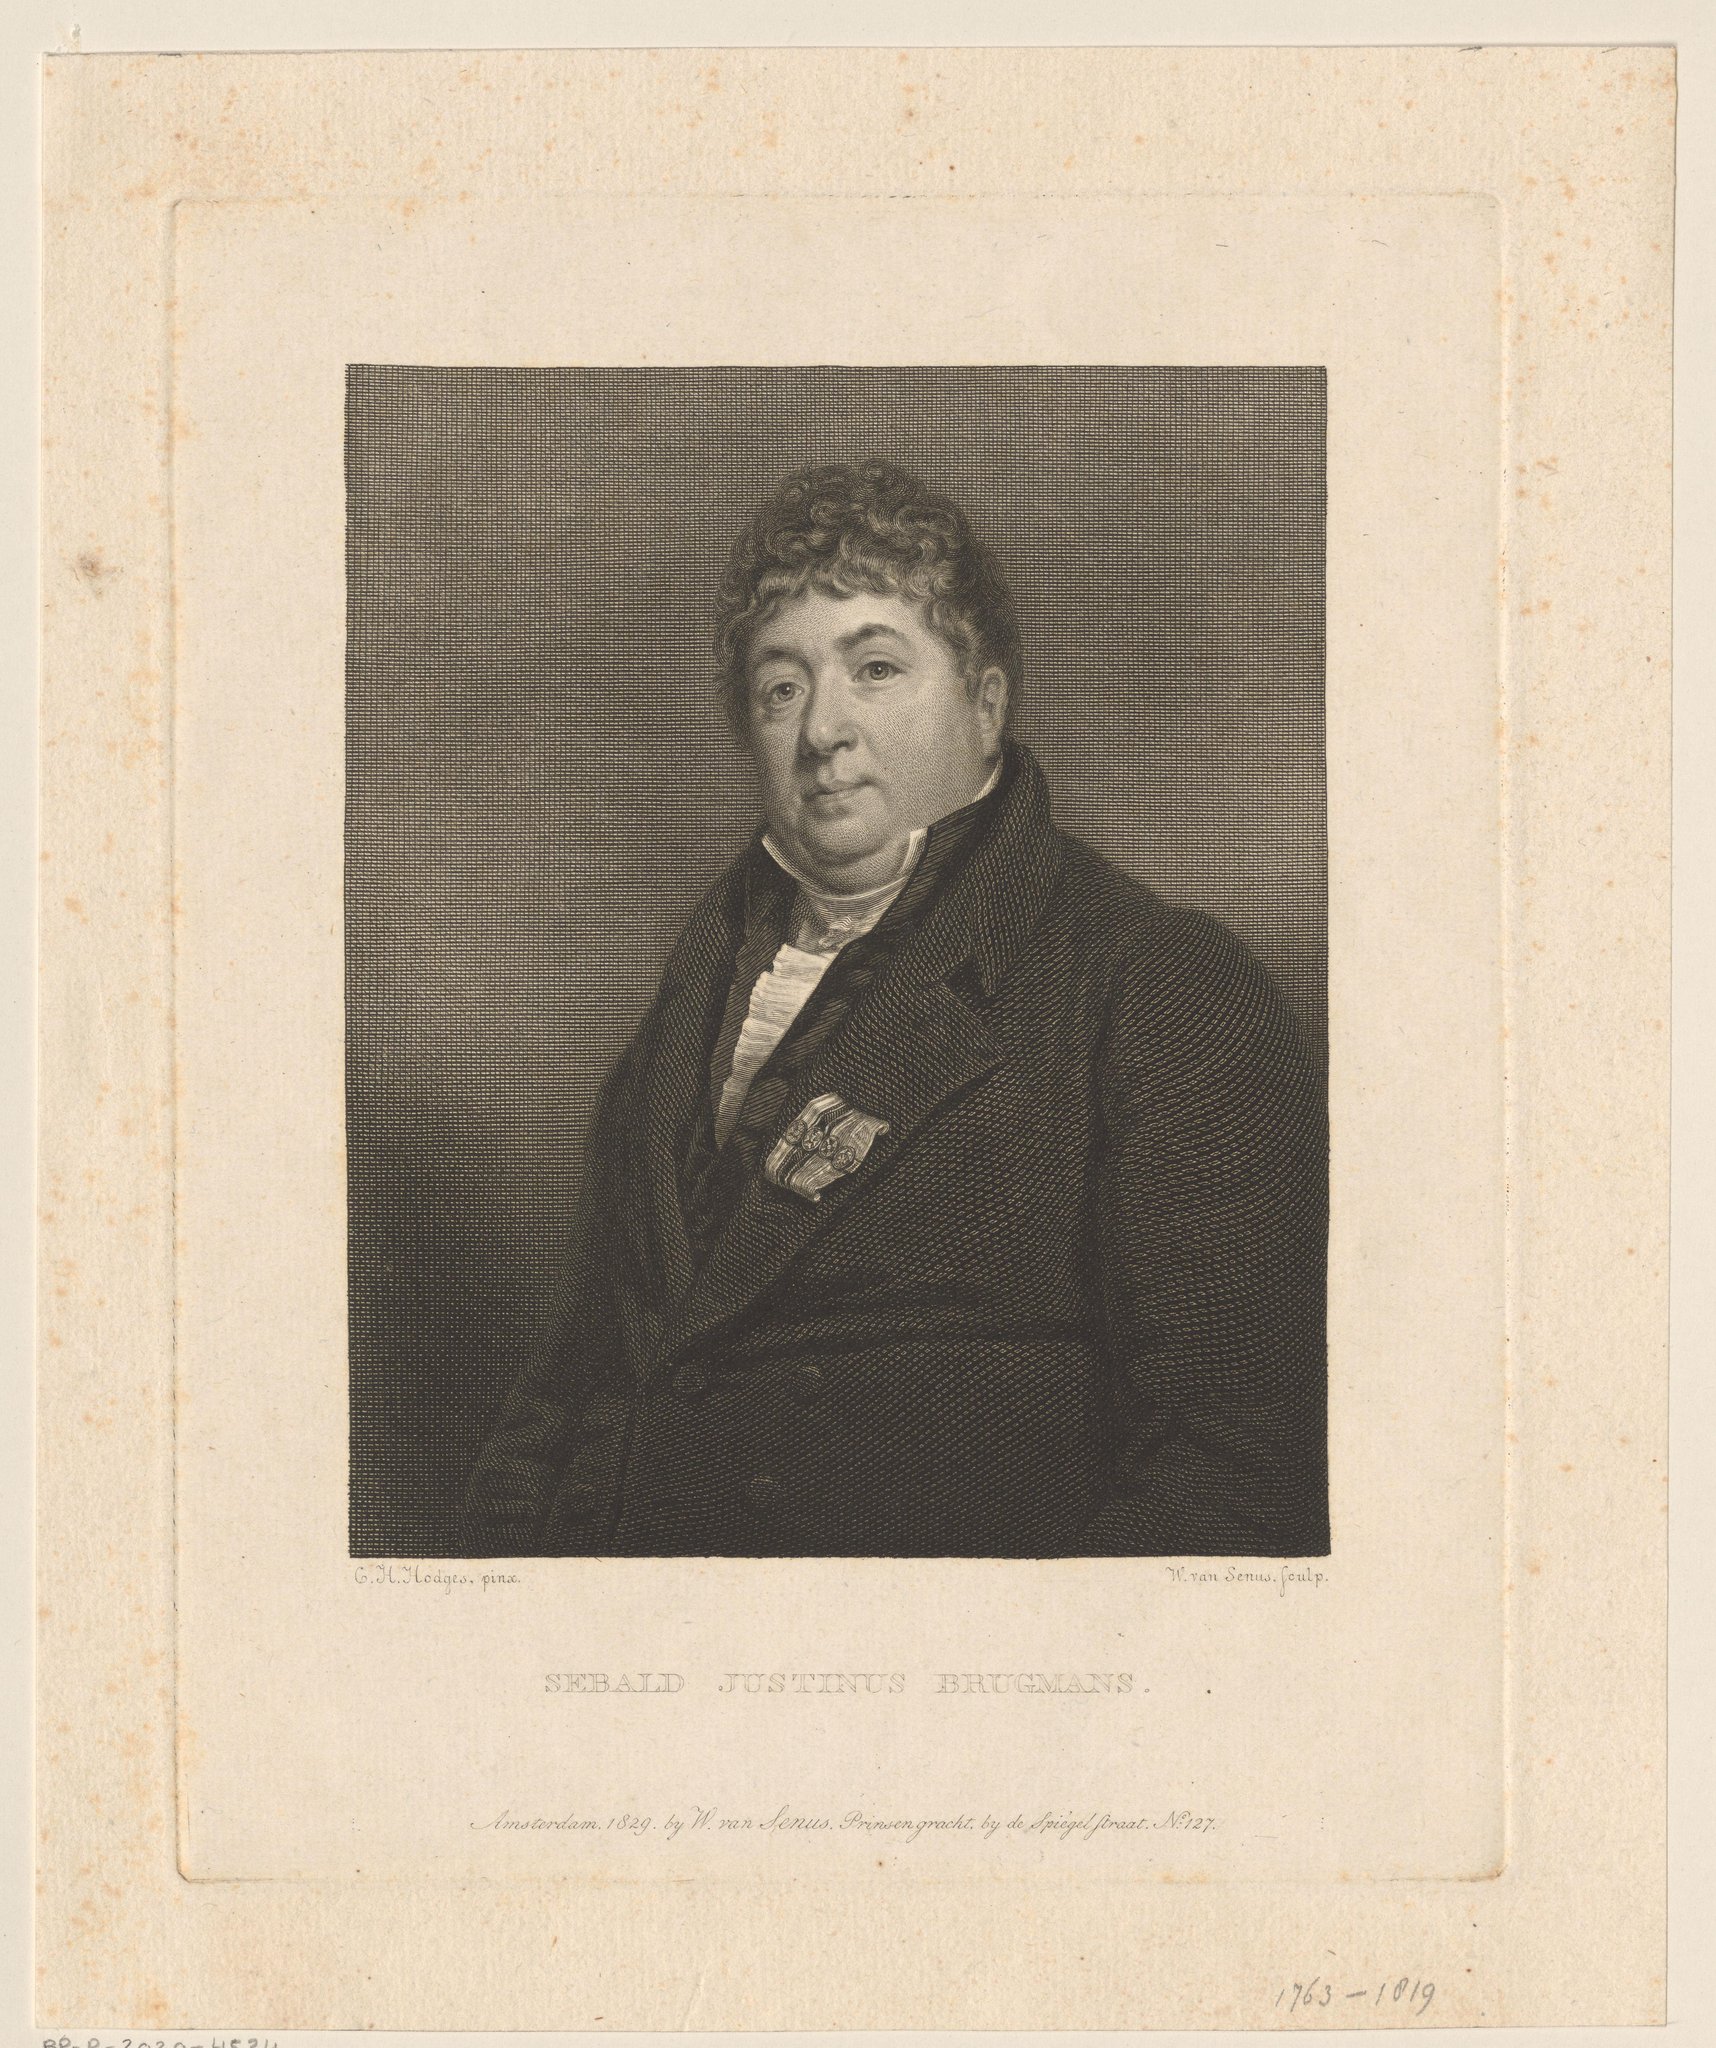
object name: print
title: Portret van Sebald Justinus Brugmans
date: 1829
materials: paper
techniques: engraving, etching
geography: amsterdam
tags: historical persons, physician, doctor, professor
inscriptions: date